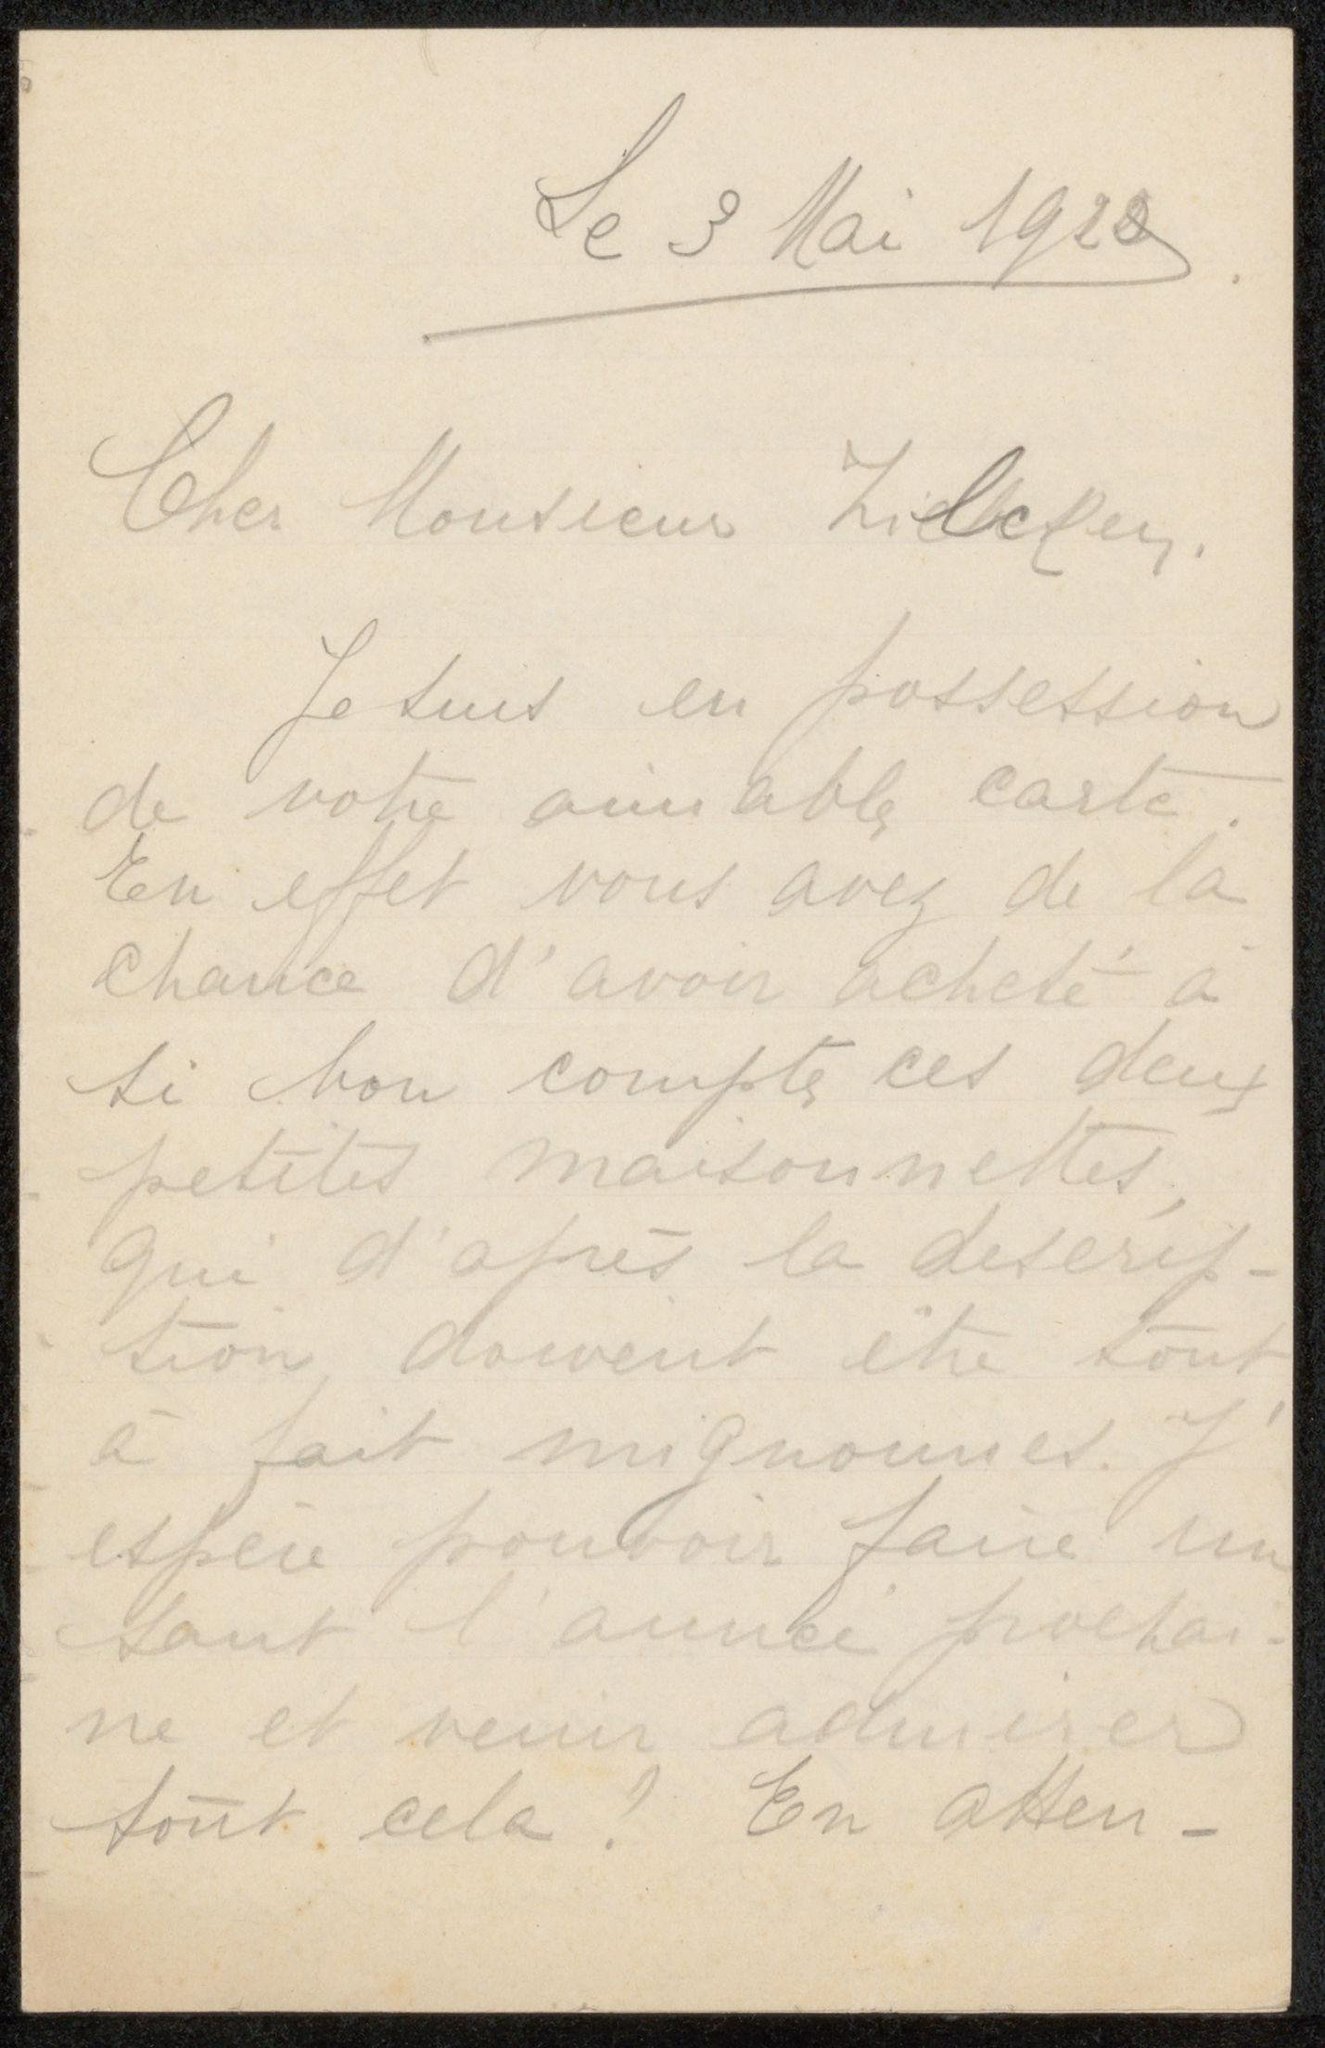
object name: letter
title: Brief aan Philip Zilcken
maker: rose imel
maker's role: draughtsman, painter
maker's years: 1901-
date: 1920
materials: pencil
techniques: writing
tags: the hague, painter, draughtsman, philip zilcken, paris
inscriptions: collector's mark: ‘RPK’